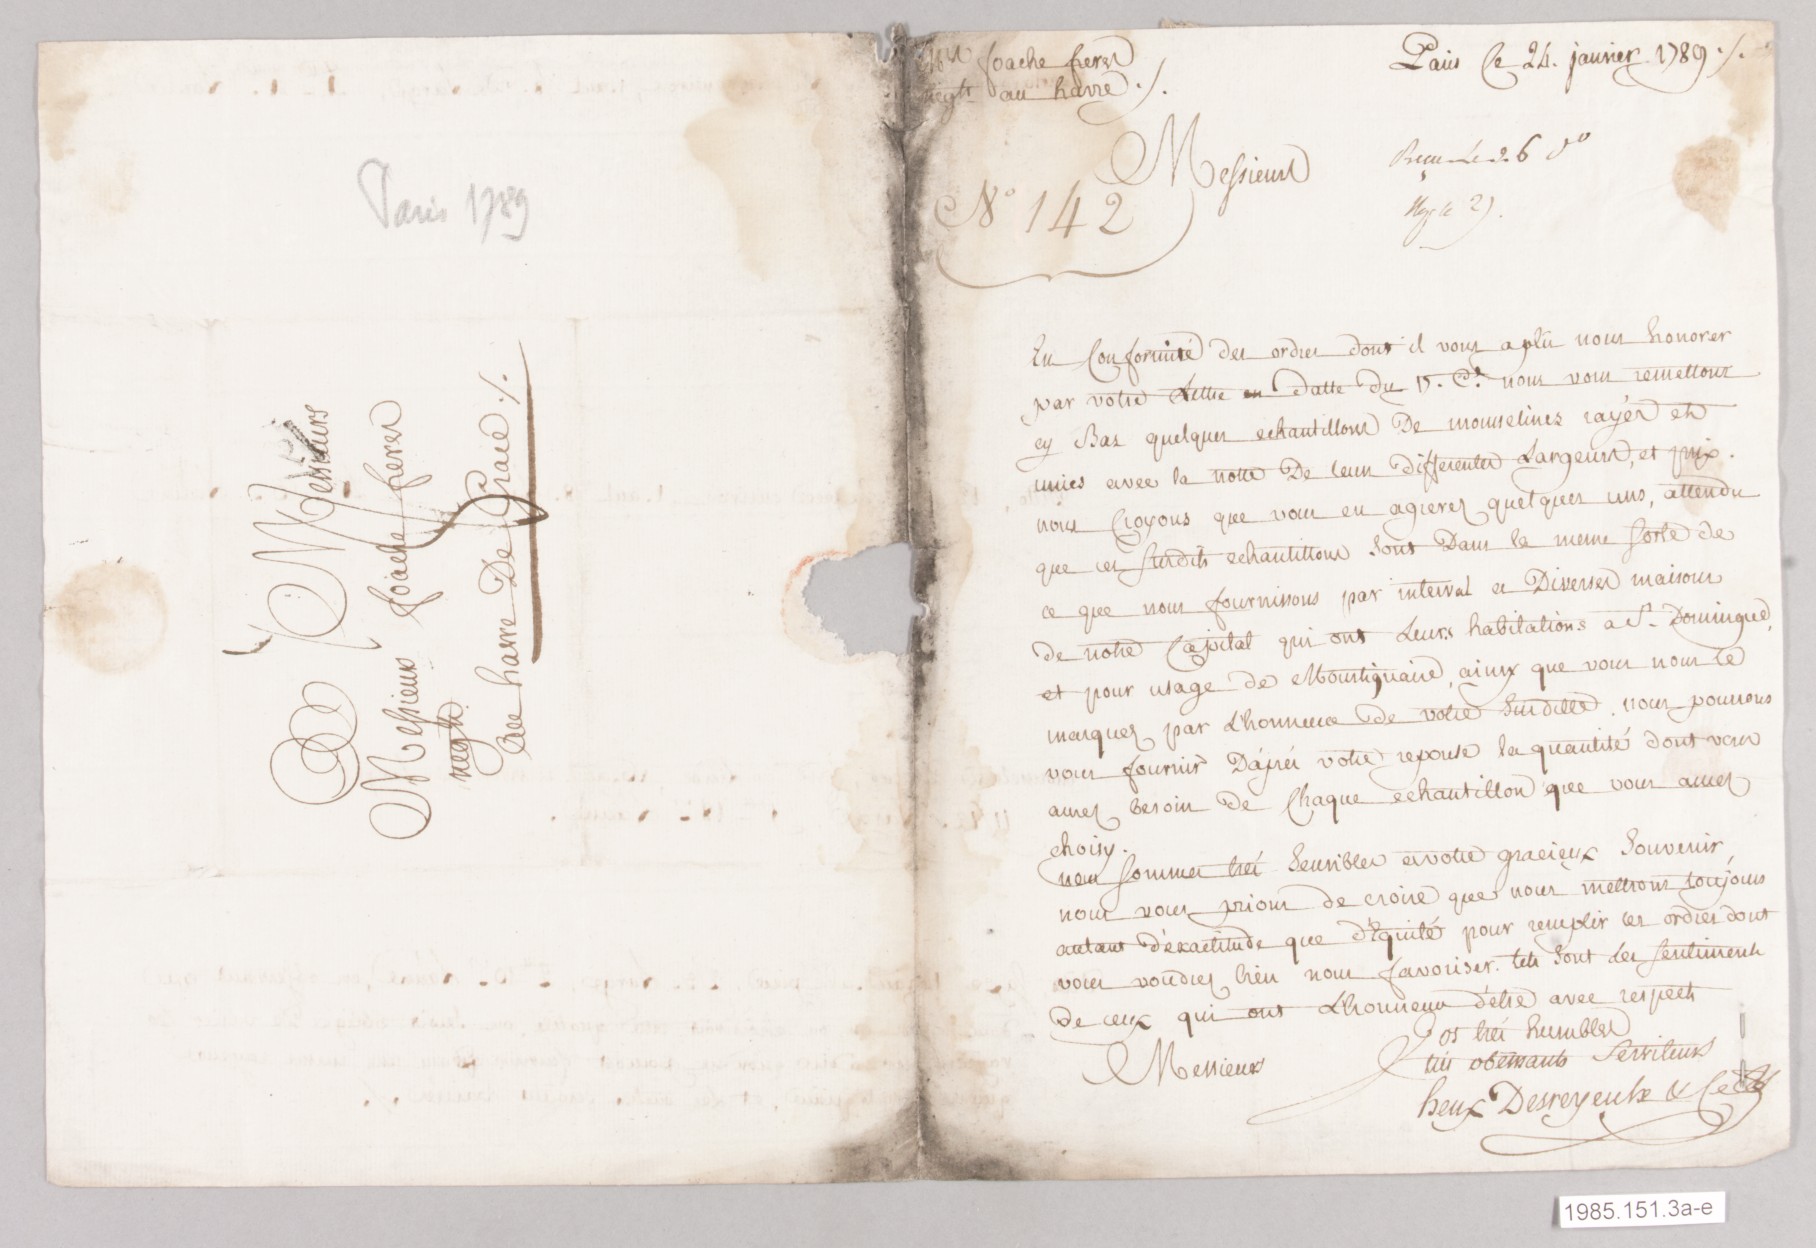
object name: sample and letter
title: Textile swatch to accompany letter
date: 1767-1800